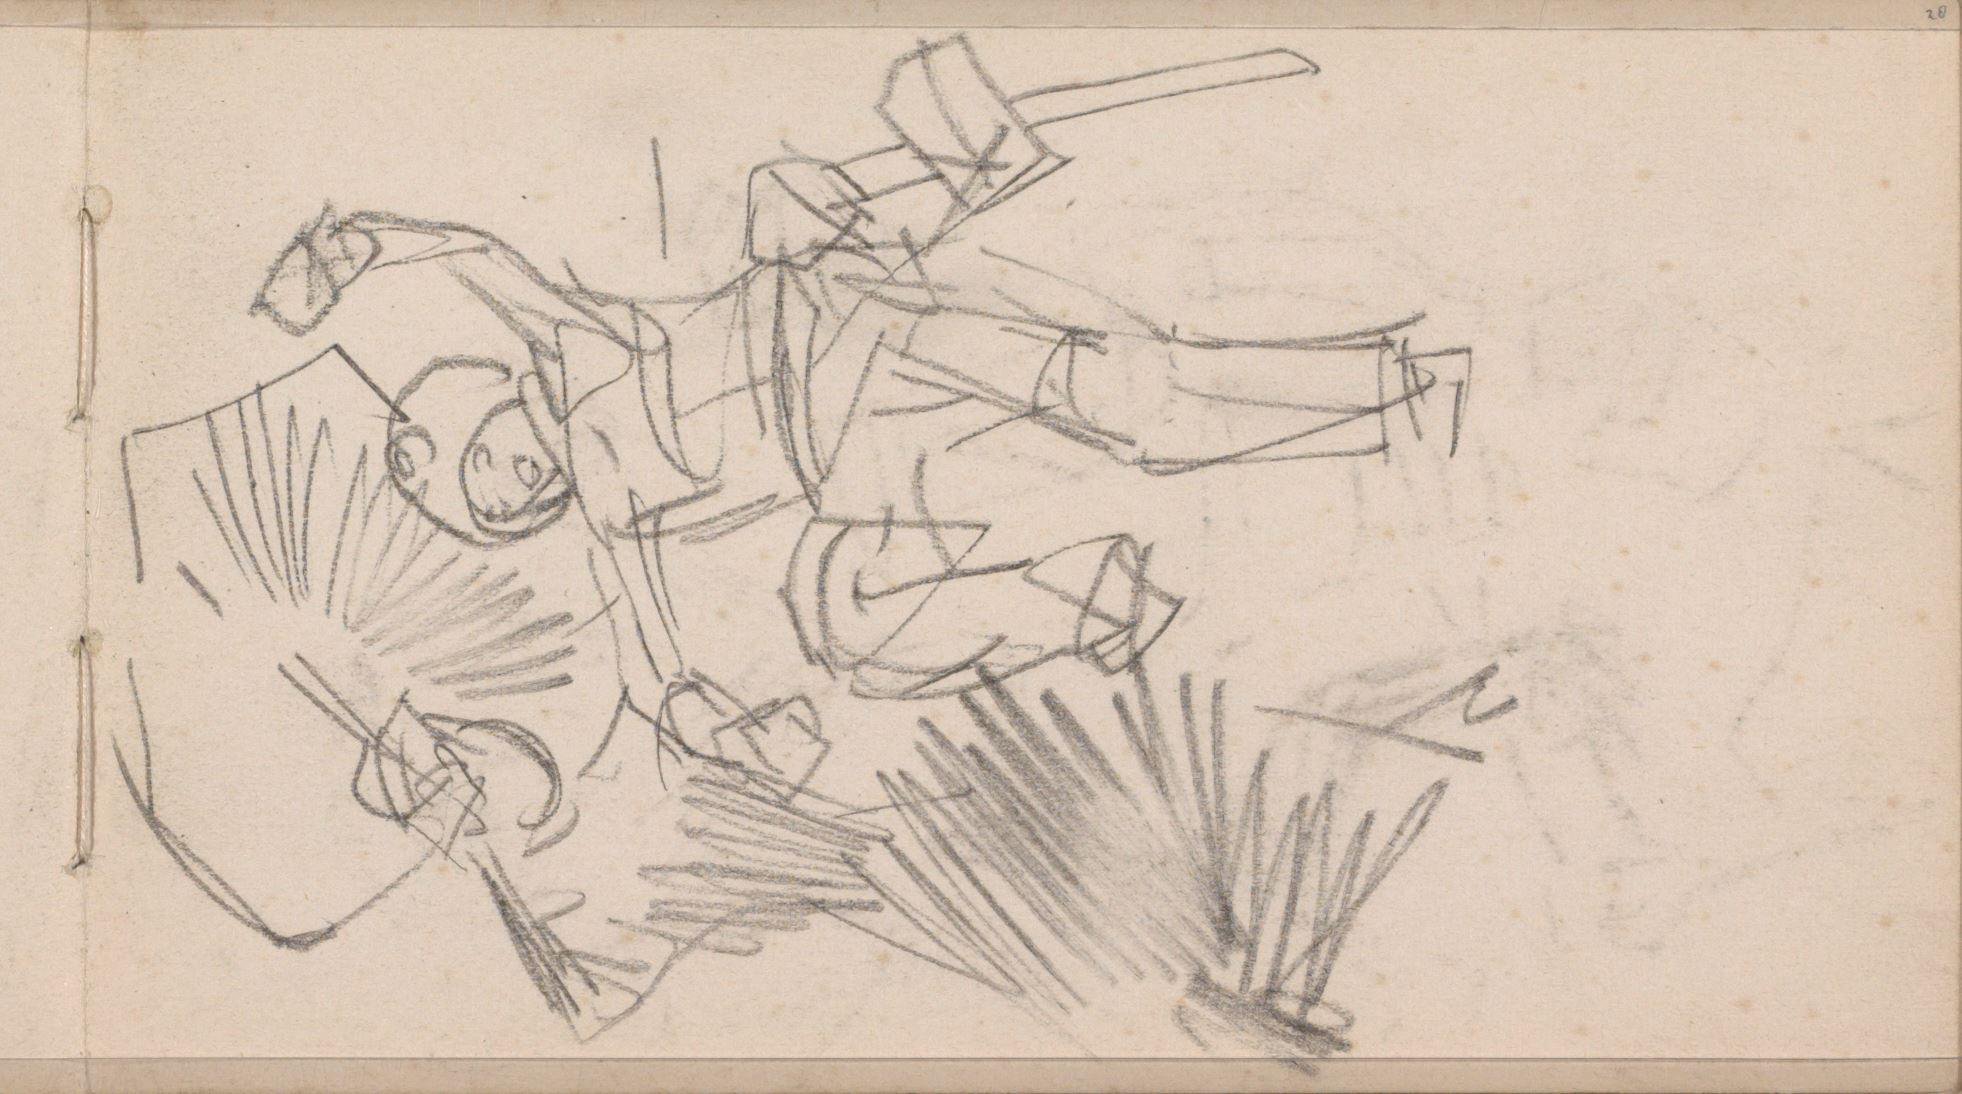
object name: sketchbook leaf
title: Figuur met opgeheven armen en been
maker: george hendrik breitner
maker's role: draughtsman, painter, print maker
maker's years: 1857-1923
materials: chalk, paper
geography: amsterdam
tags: arm raised upward, standing on one leg, the other leg forward, bent and drawn up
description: Pagina 28 uit een schetsboek met 32 bladen.